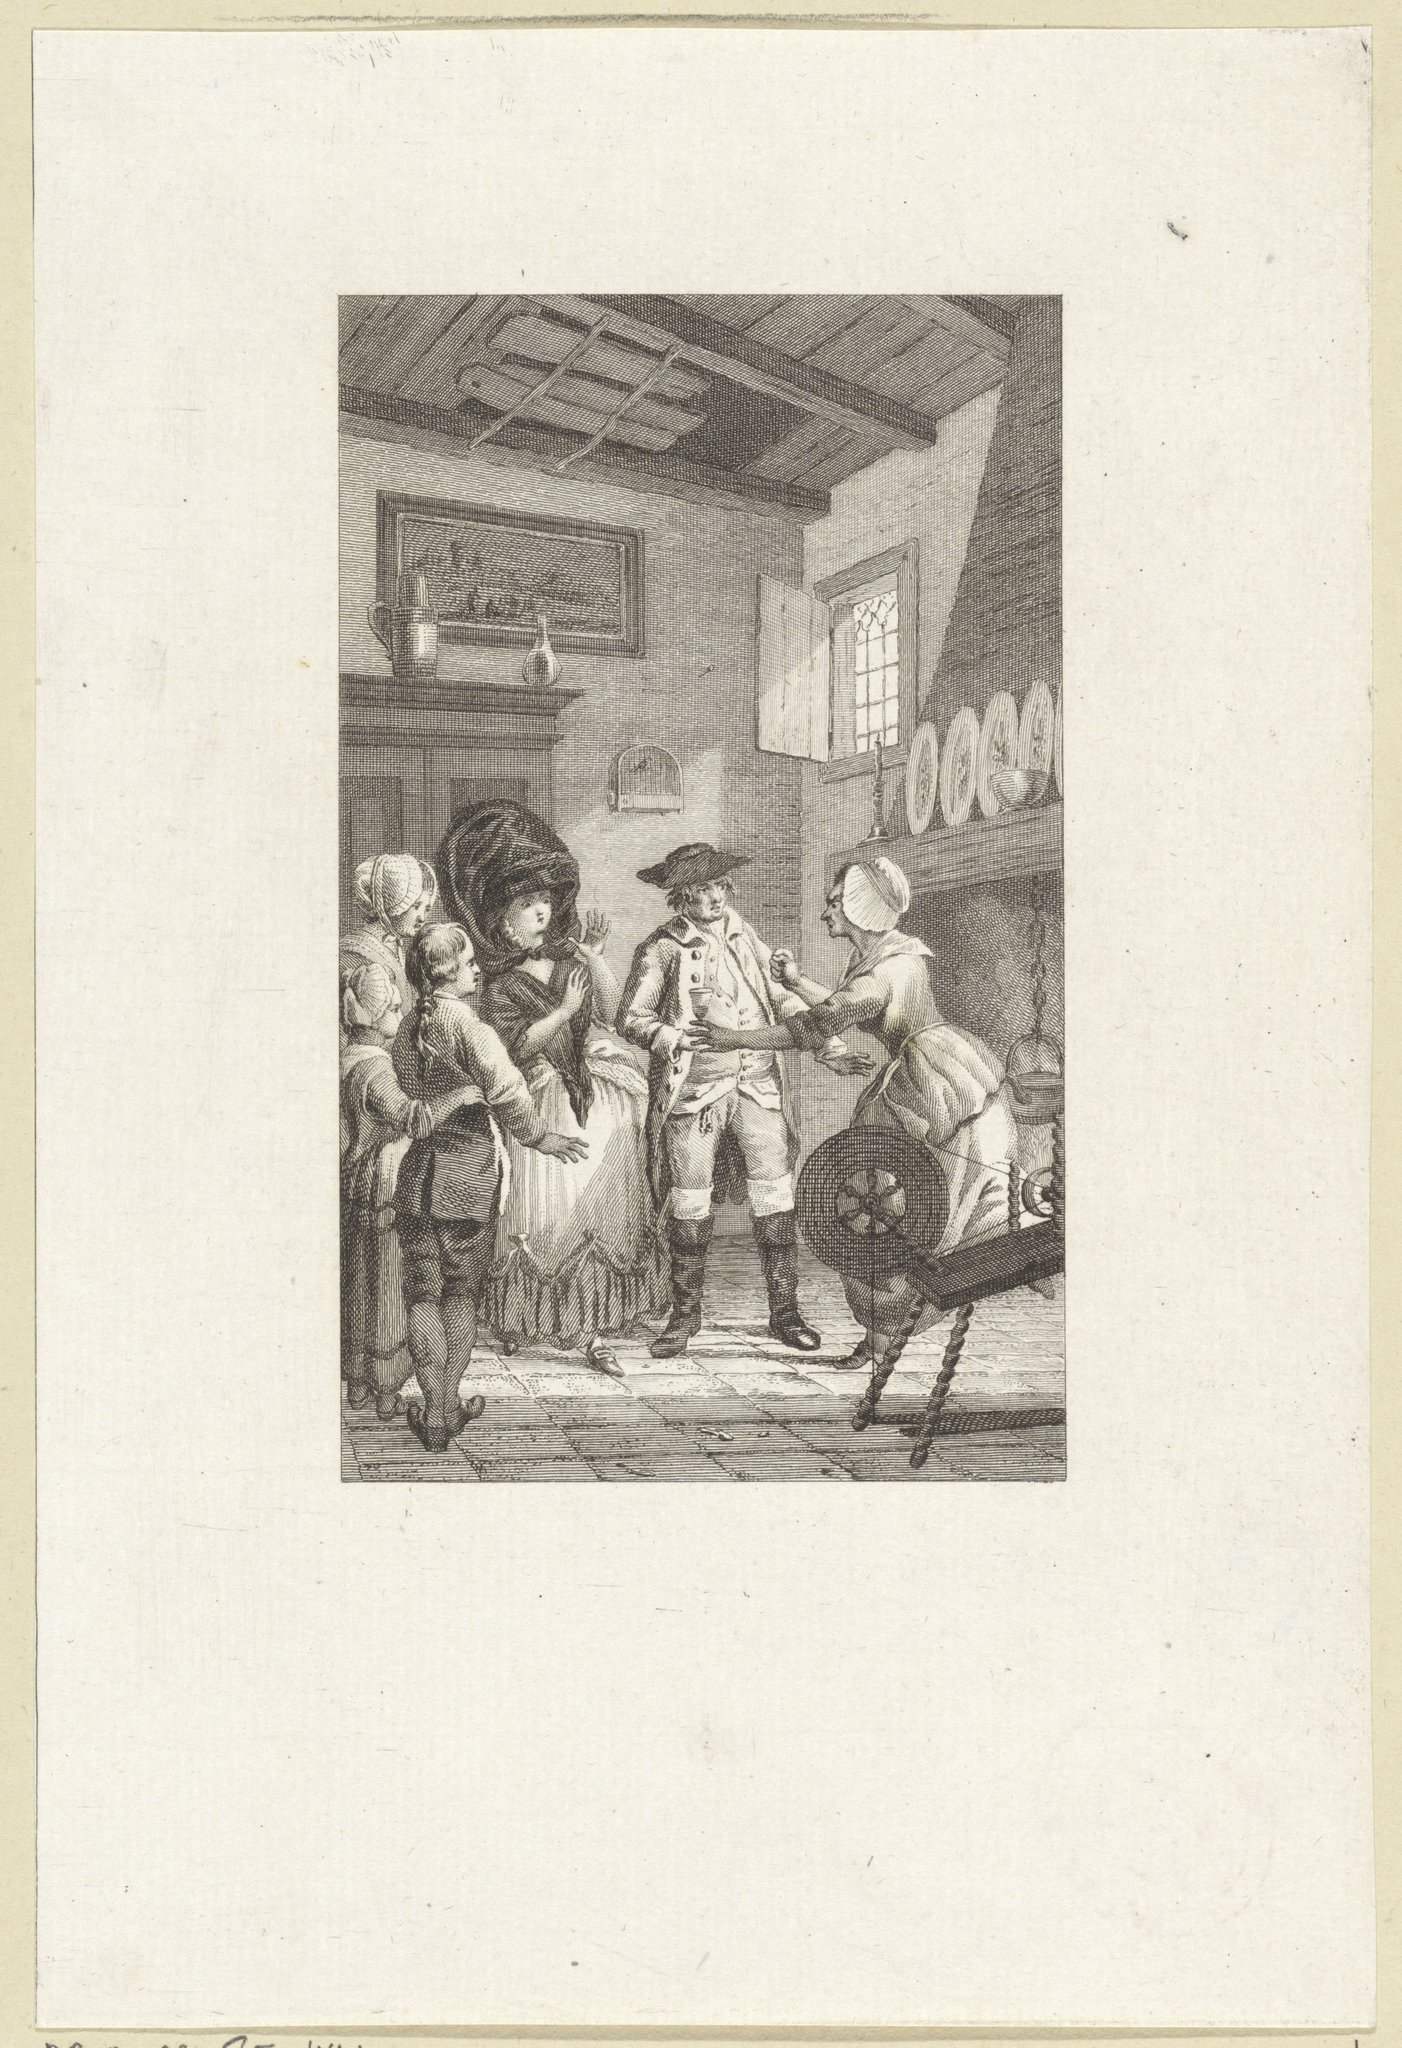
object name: print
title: Vrouw toont haar gebalde vuist aan een andere vrouw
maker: reinier vinkeles (i)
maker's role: draughtsman, print maker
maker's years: 1741-1816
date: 1790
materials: paper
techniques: engraving, etching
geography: amsterdam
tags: arm raised, with fist, open hearth, fire-place, picture, painting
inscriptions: collector's mark: Lugt 240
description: In een vertrek laat een woedende vrouw haar gebalde vuist zien aan een andere vrouw, die daar van lijkt te schrikken. Een man en een aantal kinderen kijken toe.